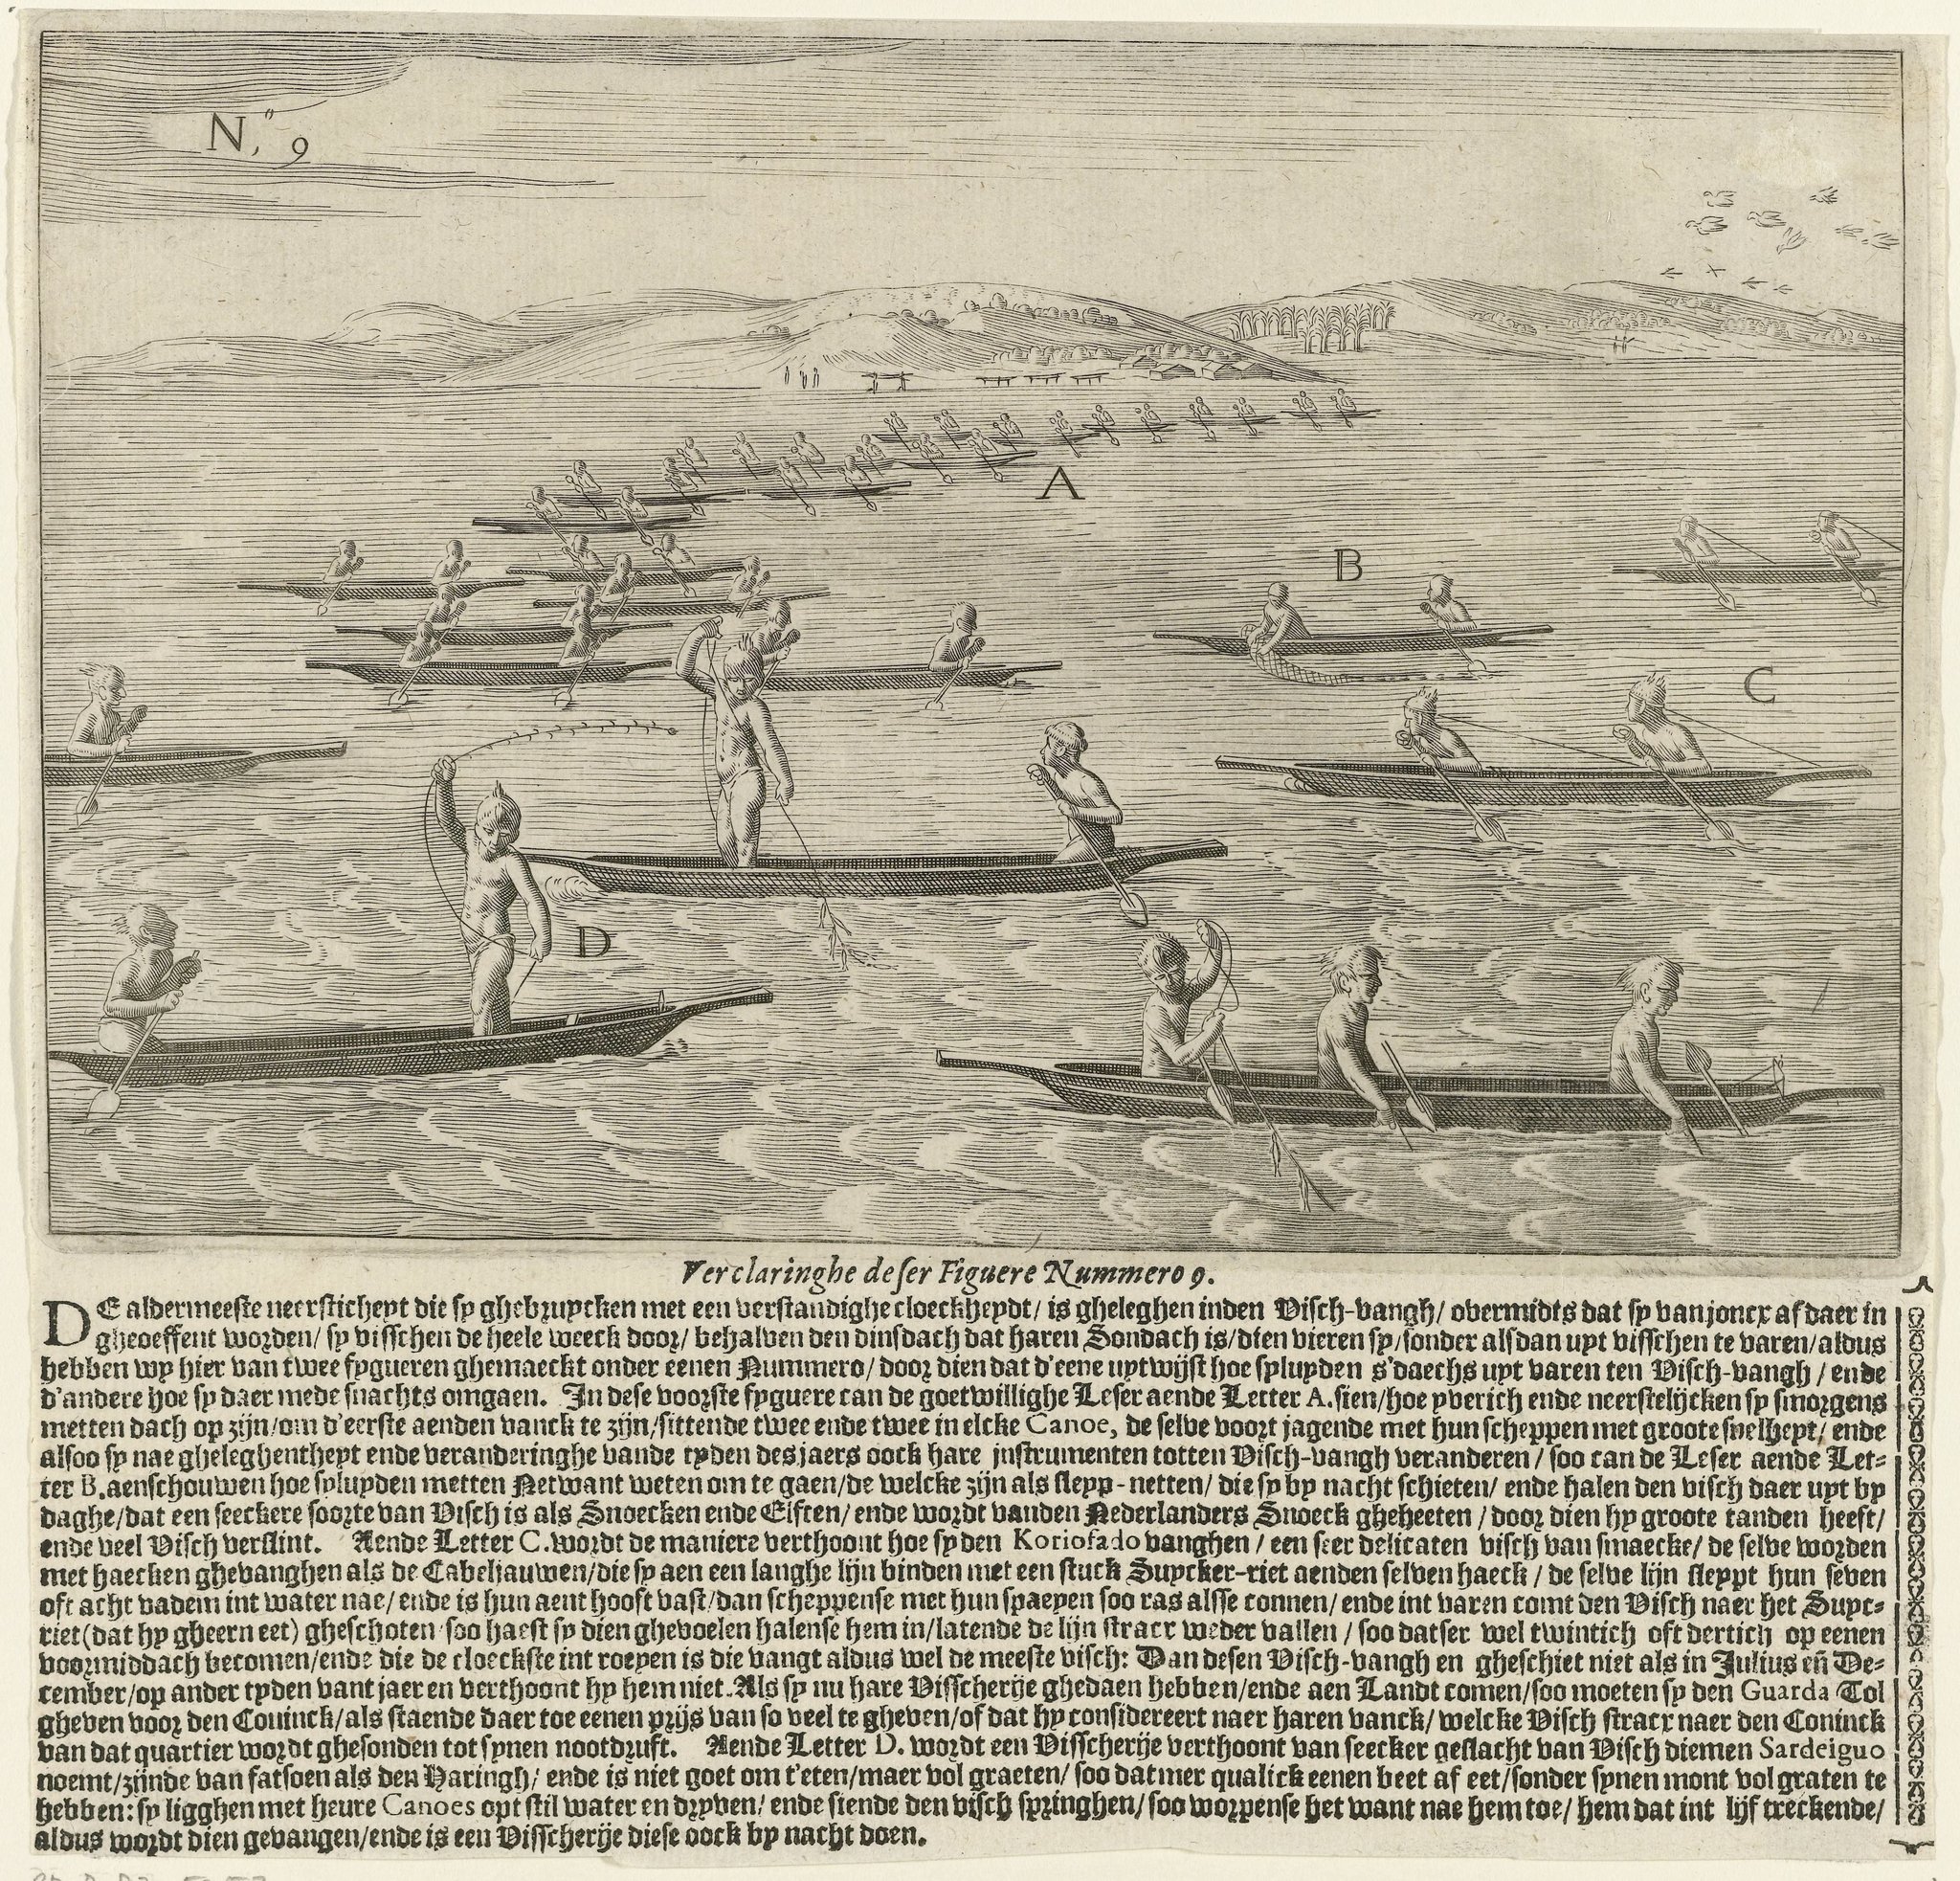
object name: print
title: Beschrijving van de goudkusten van Guinea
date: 1602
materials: paper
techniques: engraving, letterpress printing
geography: amsterdam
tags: commercial fishery, africans (+ anthropological characteristics emphasized)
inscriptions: collector's mark: Lugt 240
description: Illustratie uit: P.D.M. [= Pieter de Marees]. Beschryvinge ende historische verhael, vant gout koninckrijck van Gunea. Amsterdam: gedrukt bij Cornelis Claesz., 1602.